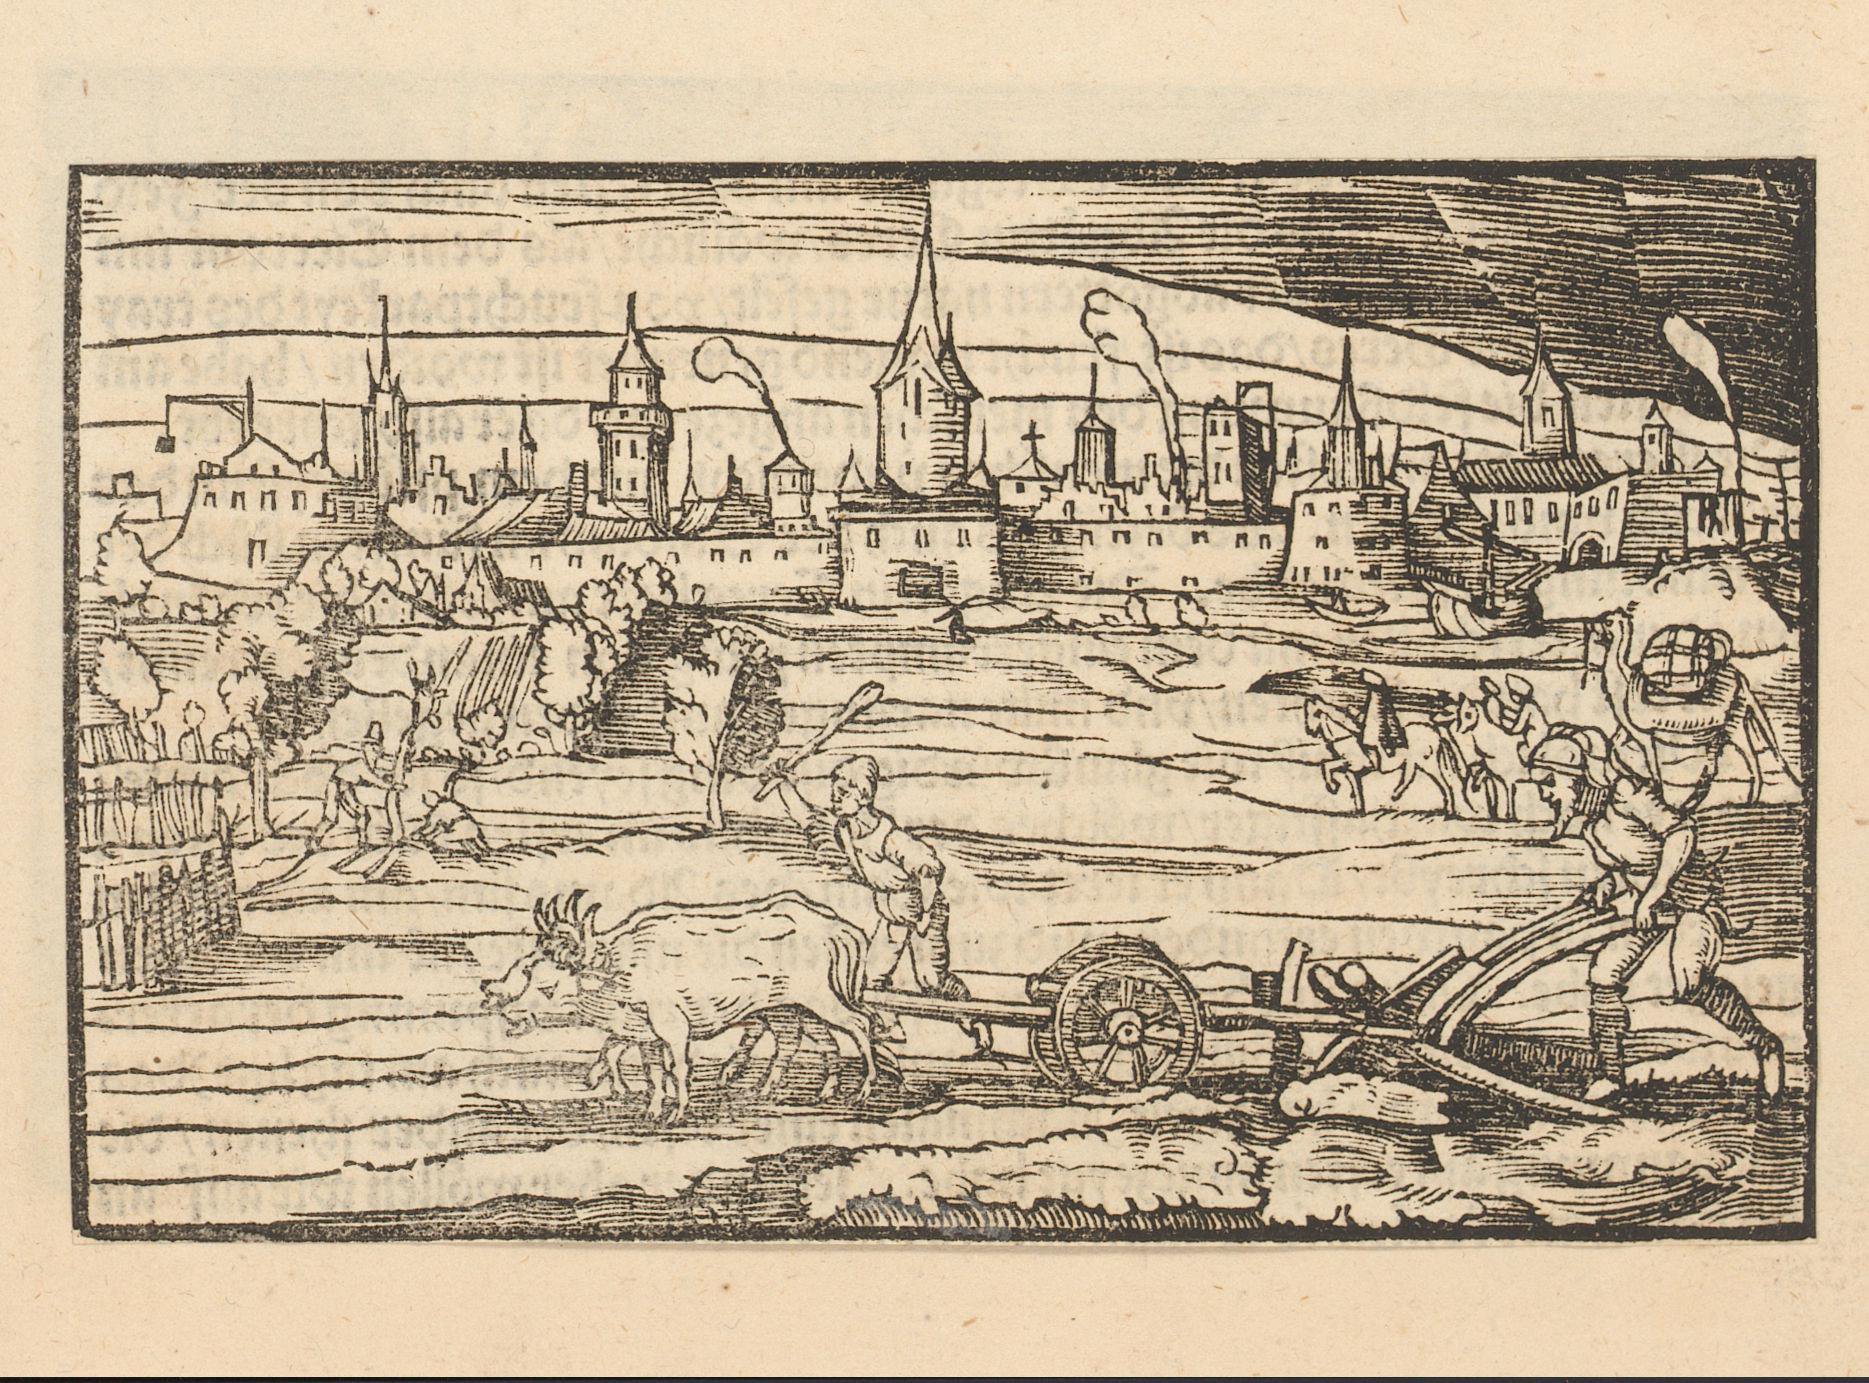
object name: album leaf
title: Ploegende boeren bij een vestingstad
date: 1490-1537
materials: paper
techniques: letterpress printing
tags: fortified city, ploughing